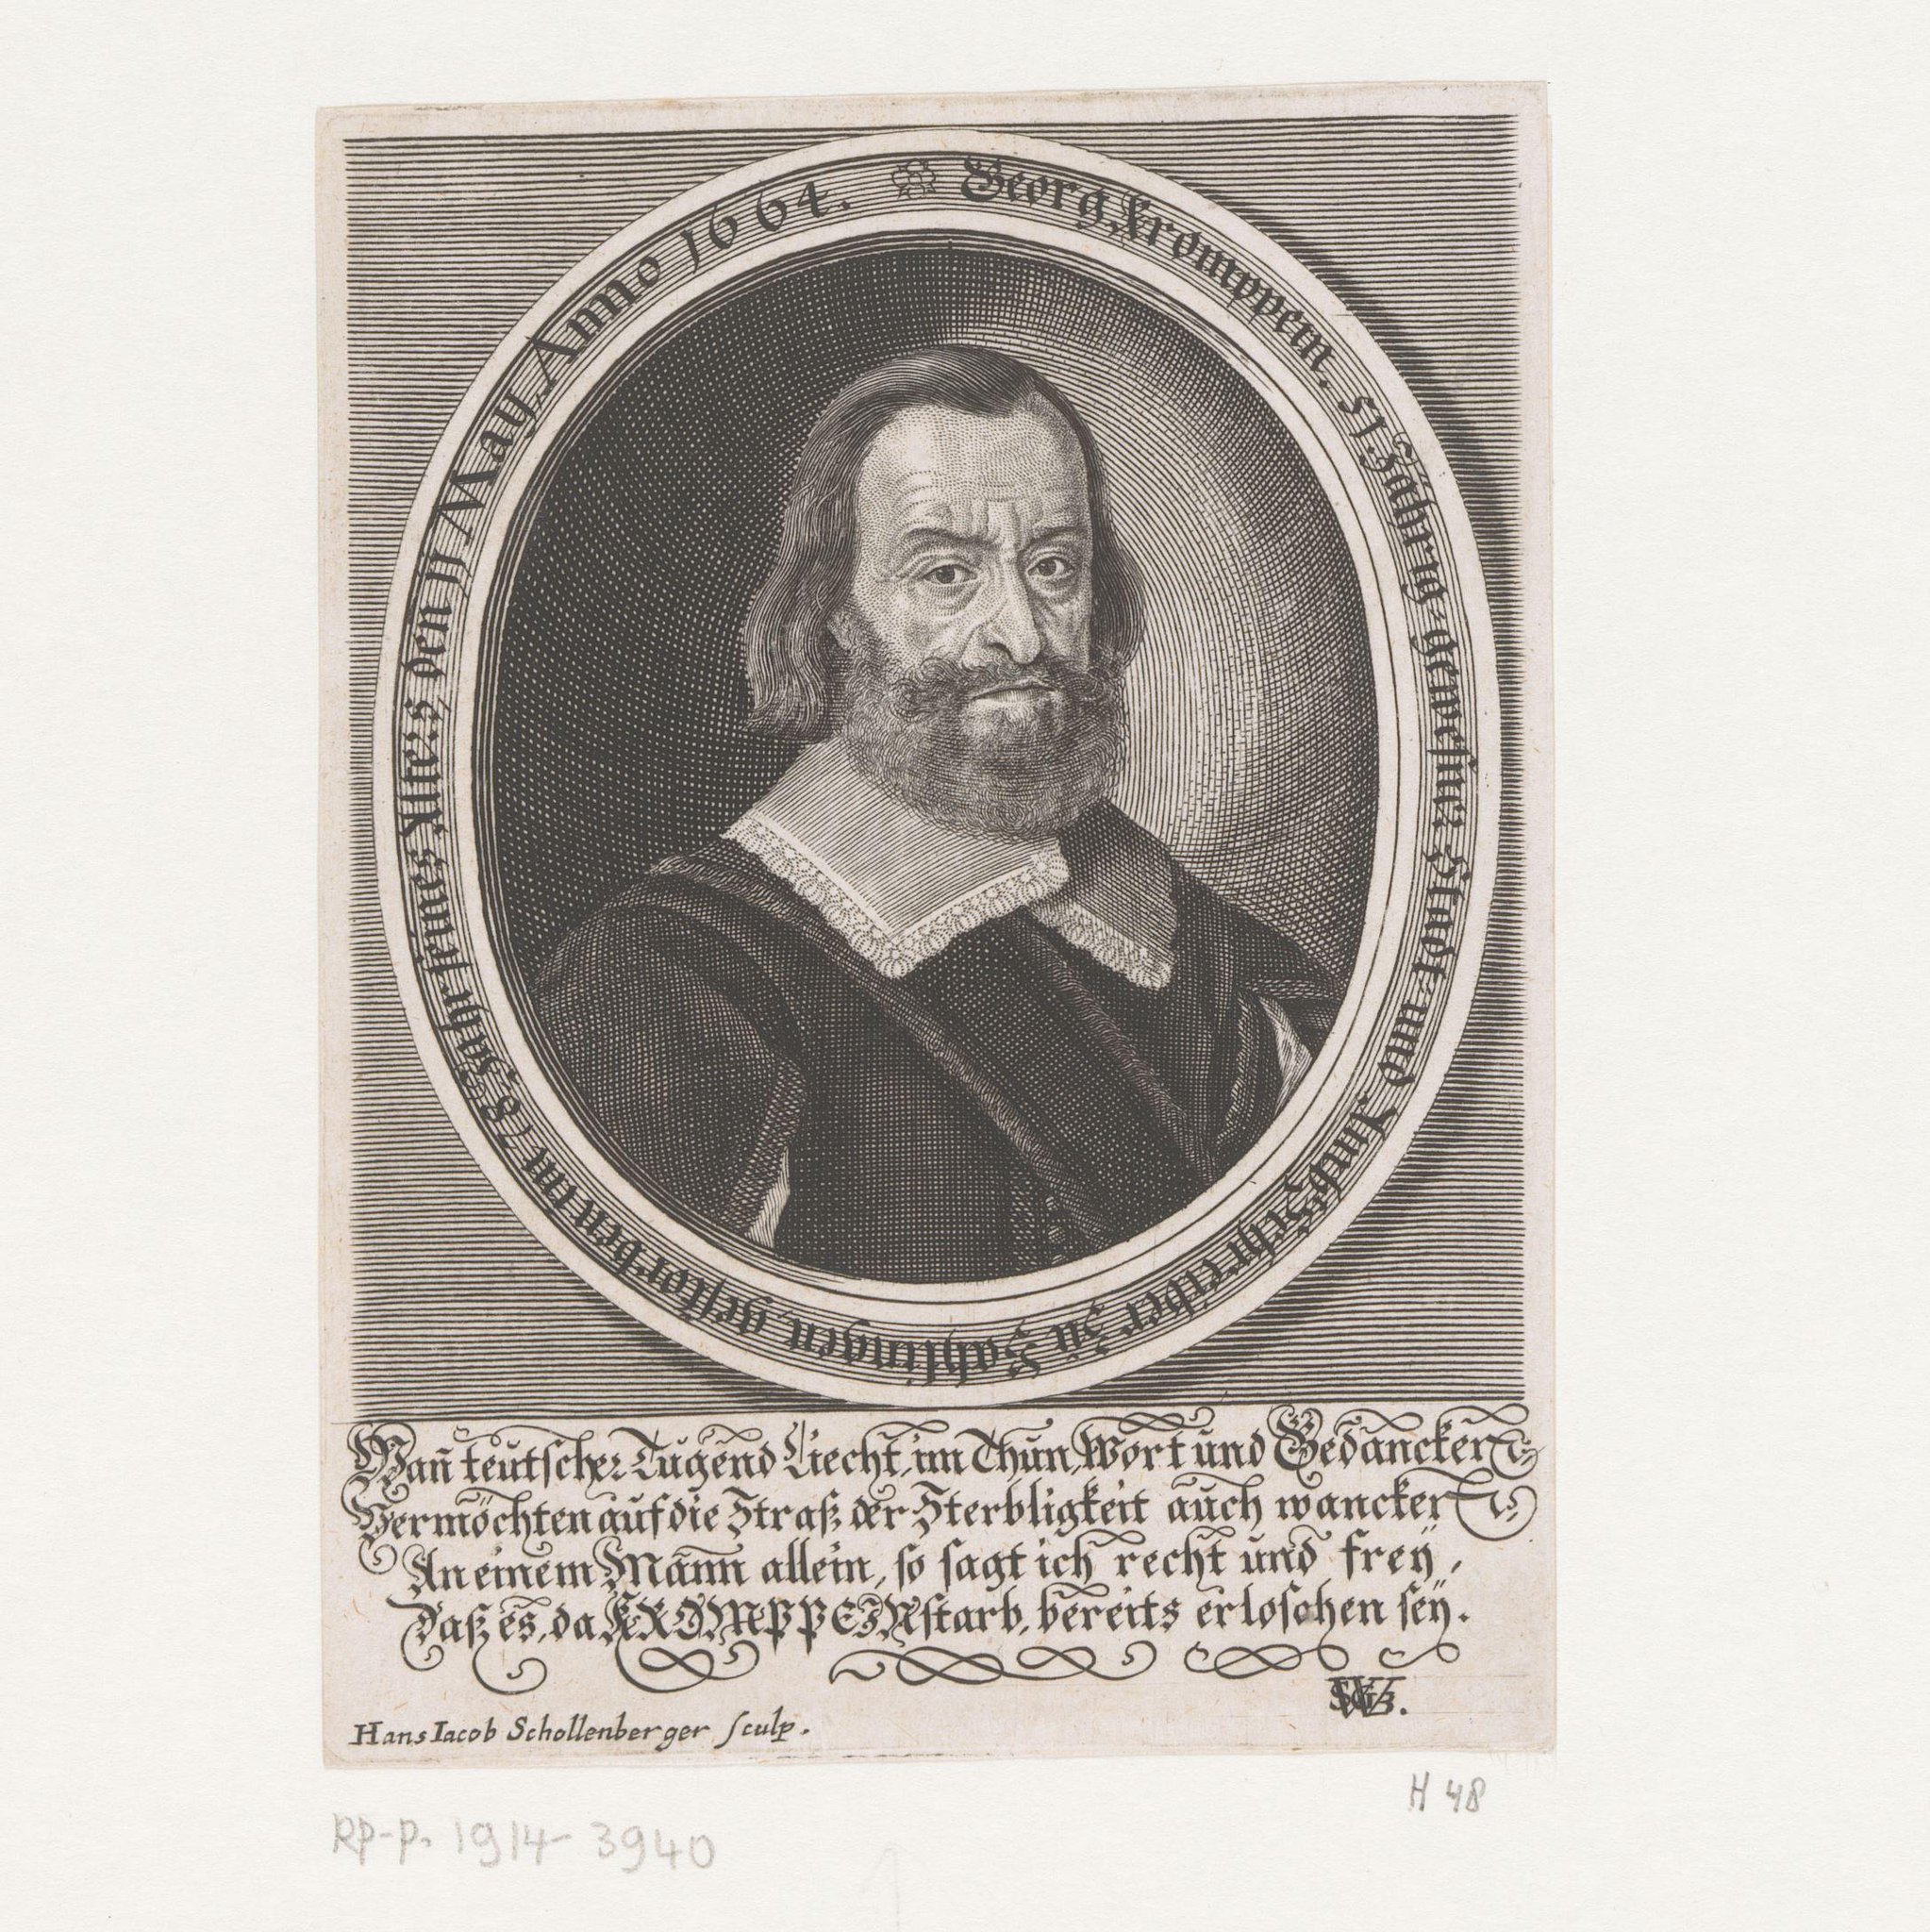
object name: print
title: Portret van Georg Kromppein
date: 1664-1689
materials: paper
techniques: engraving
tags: historical persons, portrait of a writer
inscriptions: collector's mark: Lugt 2228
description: Tekst in het Latijn in de omlijsting en in de ondermarge.